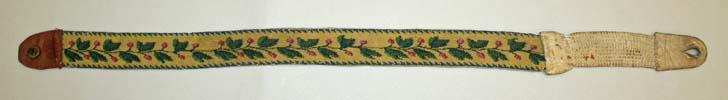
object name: belt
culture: italian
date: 1867-1900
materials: leather